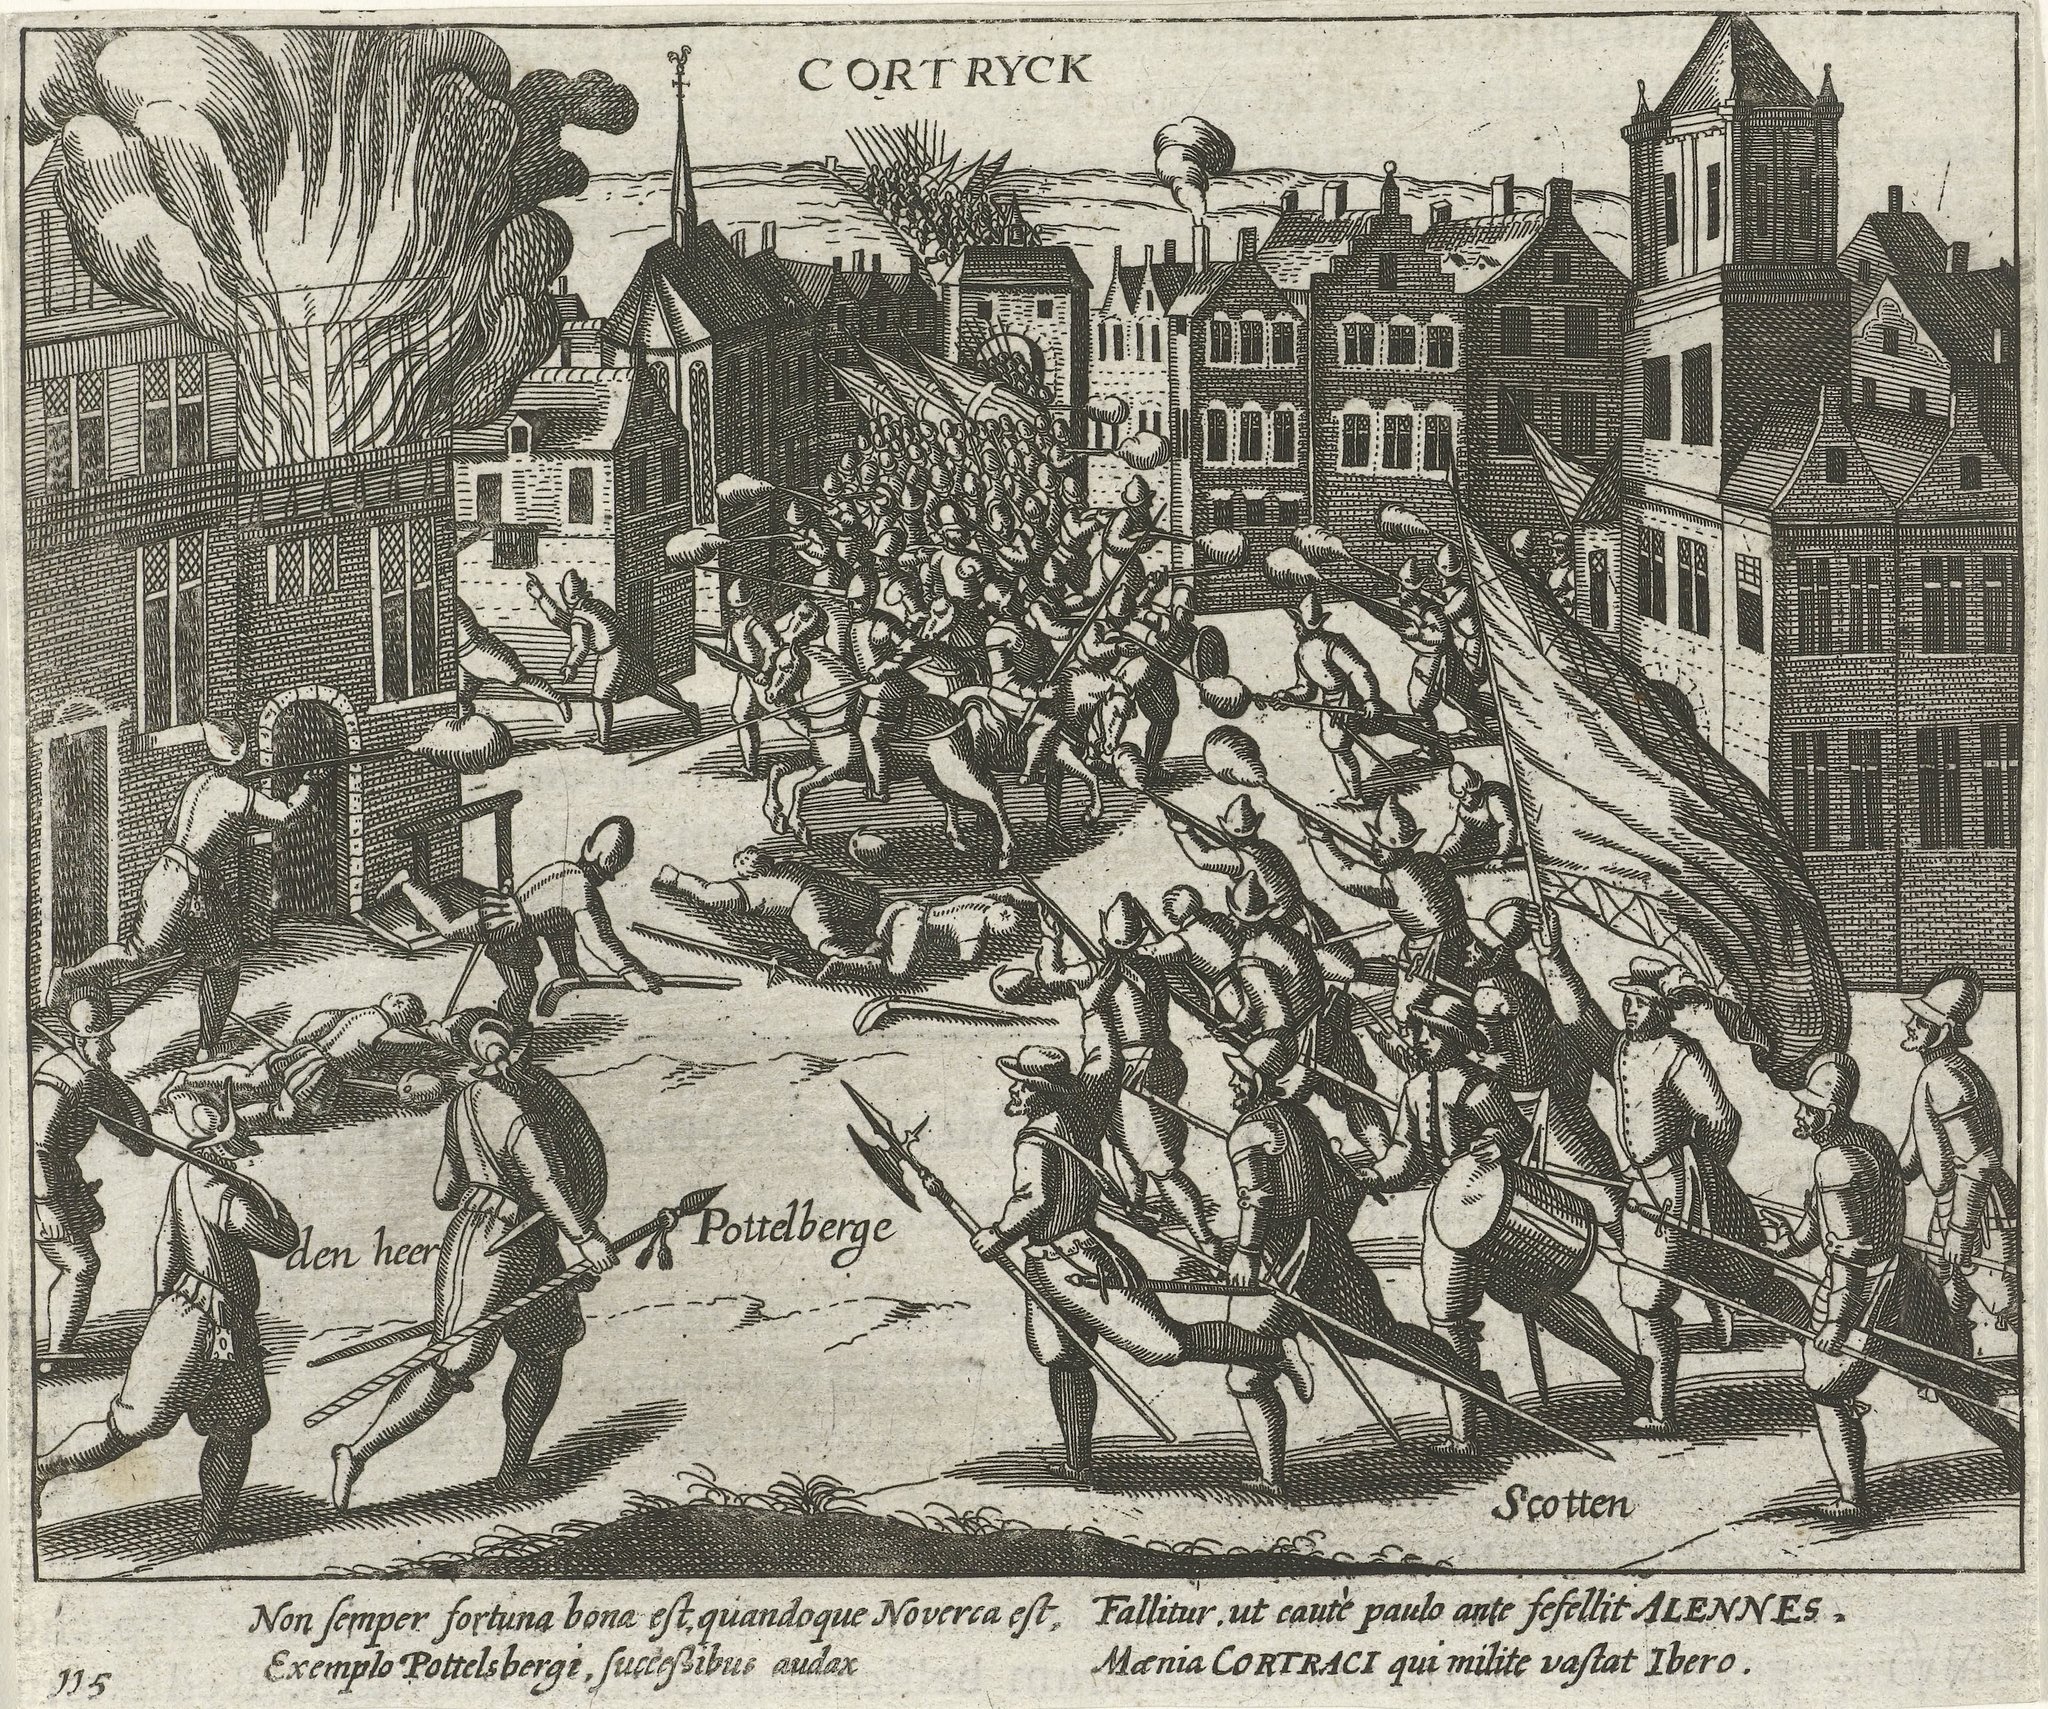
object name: print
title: Kortrijk ingenomen door de Malcontenten, 1580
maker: Anonymous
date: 1613-1615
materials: paper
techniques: etching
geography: northern netherlands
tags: capture of city (after the siege)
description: Kortrijk ingenomen door de Malcontenten, 27 februari 1580. Op de markt vechten de Malcontenten met het gelegerde garnizoen Schotten, links op de voorgrond Pottelsbergh, de baljuw van Kortrijk. Met onderschrift van 4 regels in het Latijn. Genummerd: 115. Bedrukt op achterzijde met tekst in het Latijn.